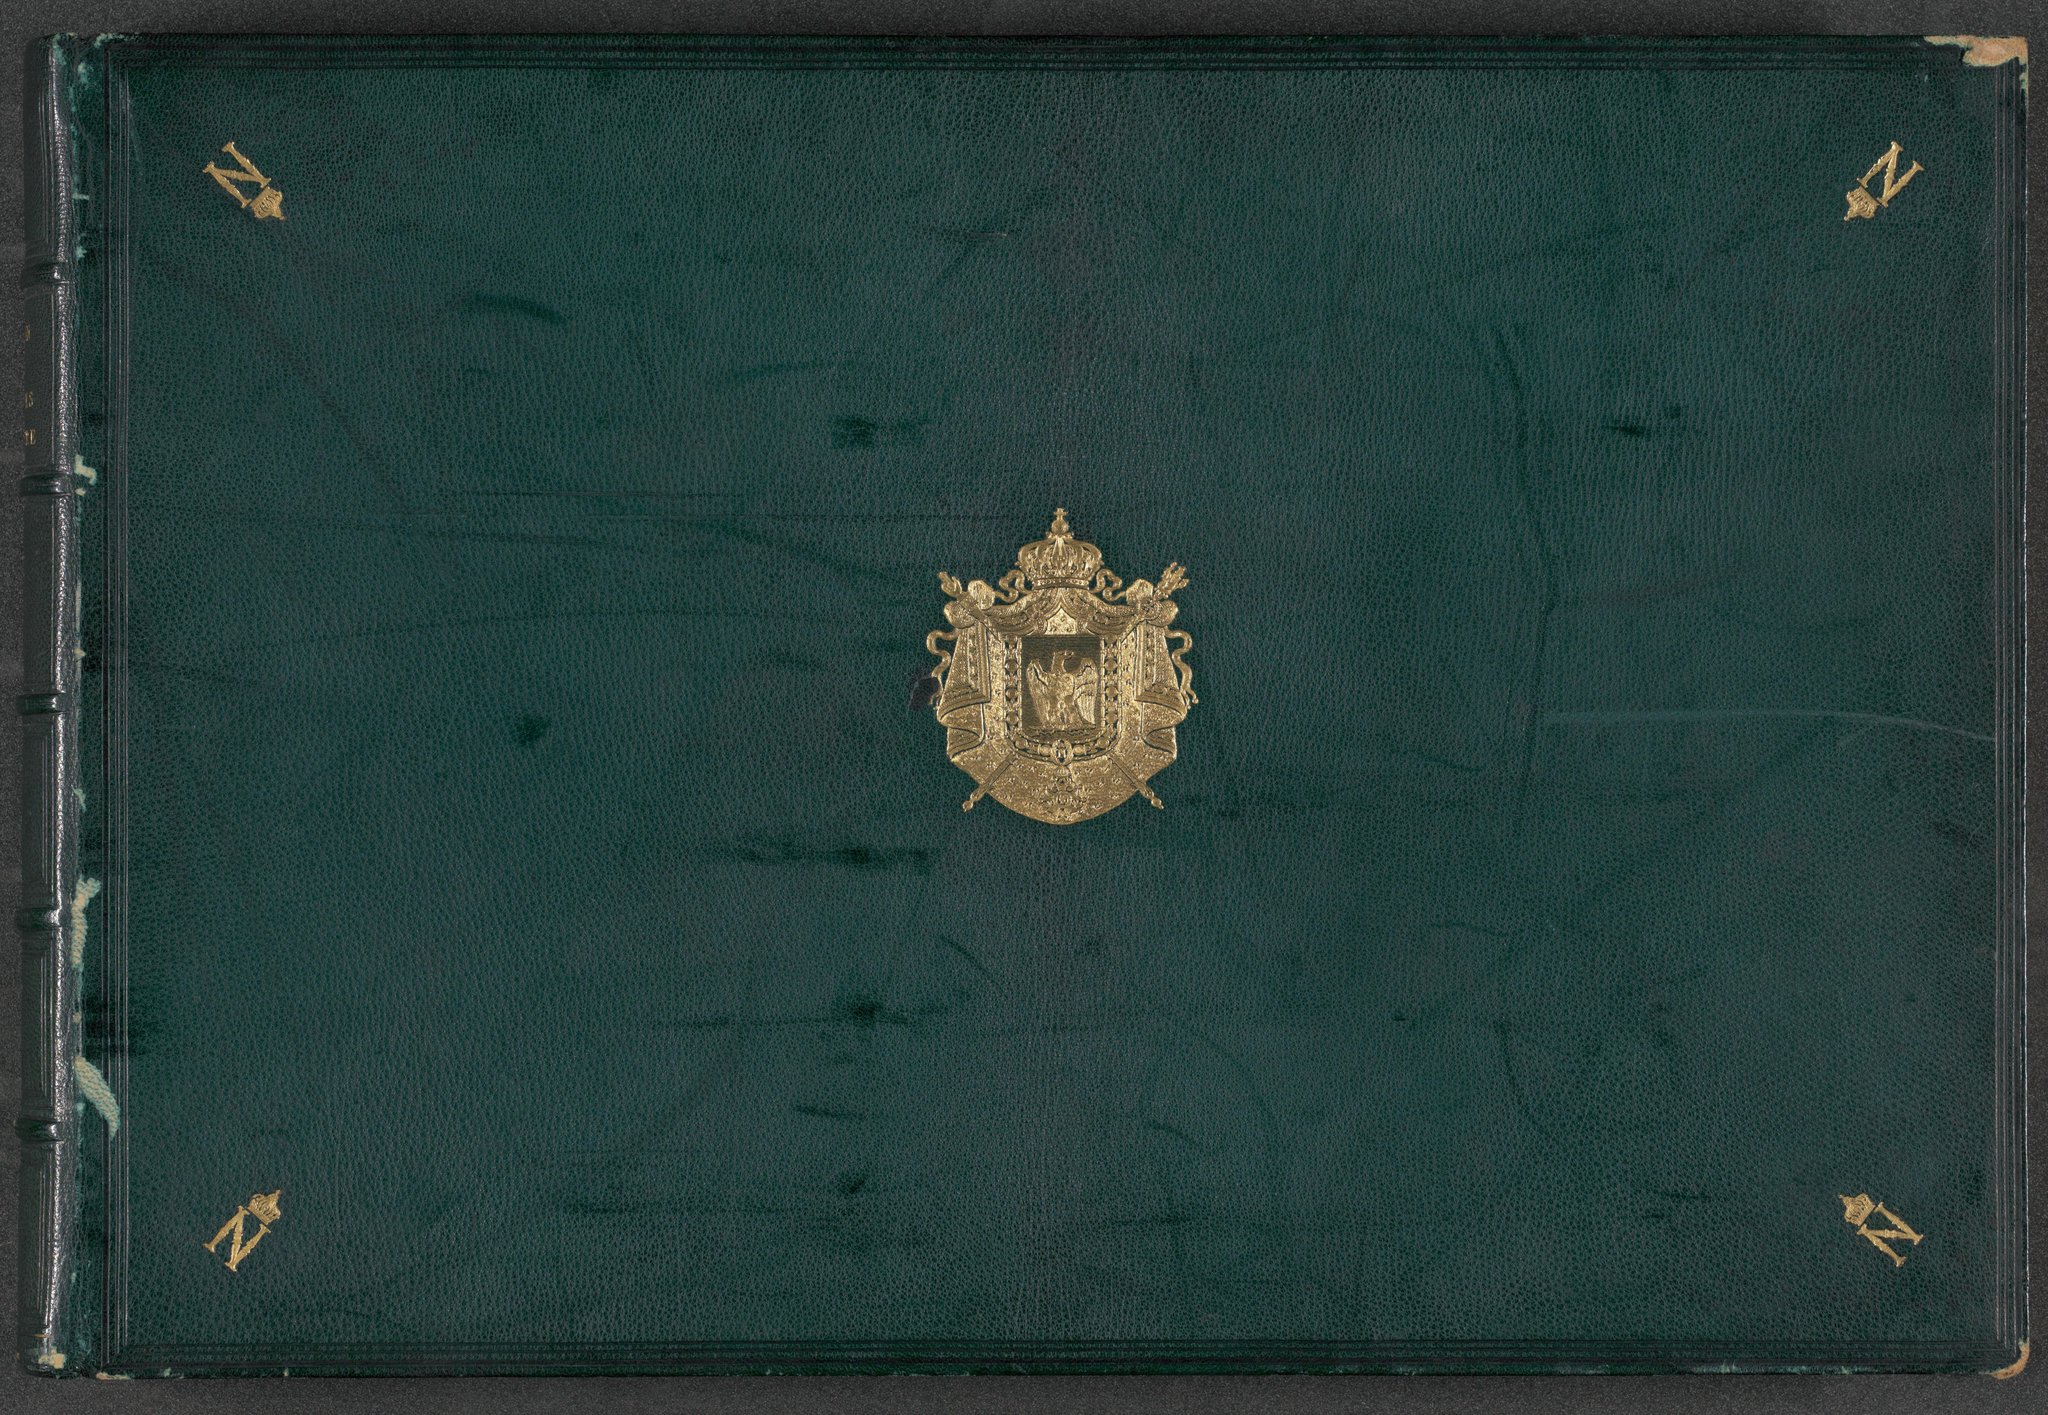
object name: scrapbook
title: Réunion des Tuileries au Louvre 1852-1857. Recueil de photographies publié par ordre de s. exc. mr. Achille Fould, ministre d'état et de la maison de l'empereur.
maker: édouard denis baldus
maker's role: fotograaf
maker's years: 1813-1889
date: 1854-1857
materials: cardboard, leather, paper, photographic support, textile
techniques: engraving, salted paper print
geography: paris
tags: permanent exhibition, museum, paris, tuileries palace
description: Fotoalbum in groen leren omslag. Op de voor- en achterzijde prijkt het wapenschild van de Franse keizer Napoleon III, in de hoeken zijn monogram. Op de rugband wordt de titel vermeld en het deelnummer. De schutbladen zijn van groen changeant met een randversiering van Franse lelies in gouddruk. Het album bevat 112 bladen met goud op snee die elk één tot drie foto's bevatten. Het album maakt deel uit van een ensemble van vier waarmee de bouw van het nieuwe Louvre tussen 1854 en 1857 stap voor stap werd gedocumenteerd in opdracht van de Franse regering. De albums werden als representatie-exemplaren aangeboden aan de keizer, bevriende staatshoofden, ministers (zoals het exemplaar van het Rijksmuseum) en bibliotheken. Er werden 36 van dergelijke sets samengesteld, elk met ongeveer 550 foto's. Slechts vier ensembles zijn bewaard gebleven.